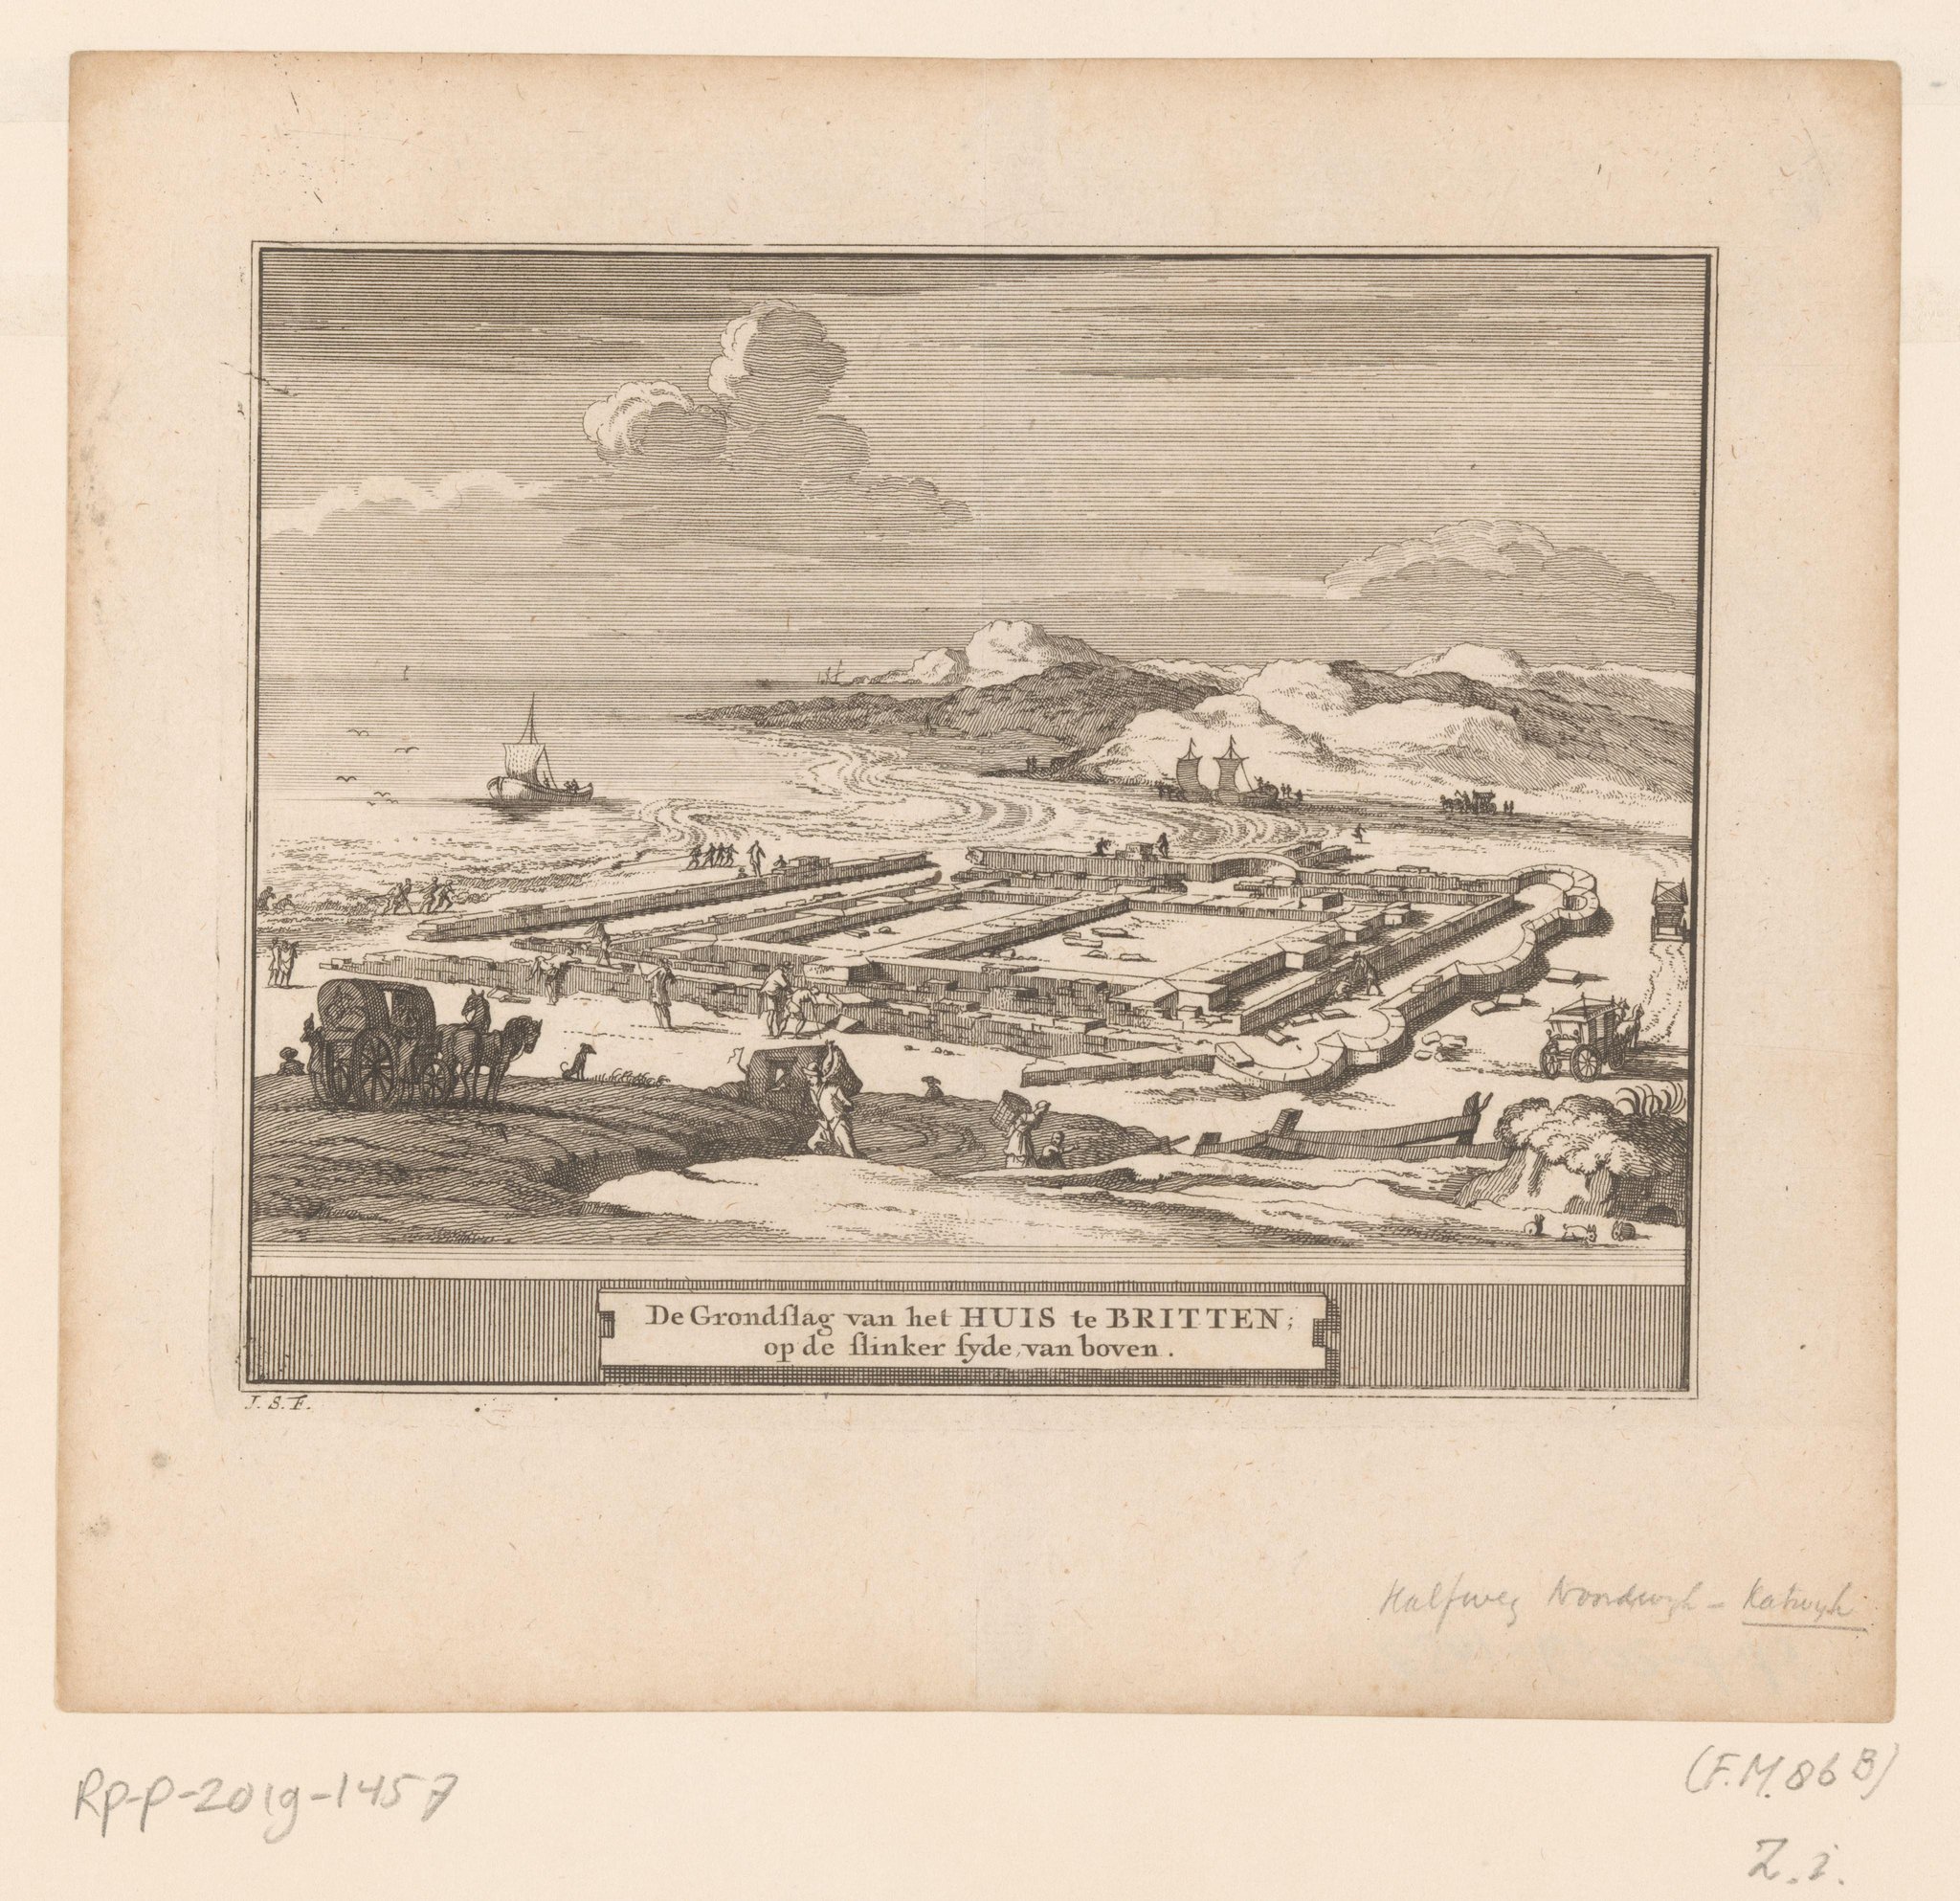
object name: print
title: De Grondslag van het Huis te Britten; op de slinker syde van boven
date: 1711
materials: paper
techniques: etching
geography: amsterdam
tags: landscape with ruins (+ city(-scape) with figures, staffage)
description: Prent voor het eerst gebruikt in: Smids, Ludolph. Schatkamer der Nederlandsse oudheden; of Woordenboek, behelsende Nederlands steden. Amsterdam: Pieter de Coup, 1711, tussen p. 44 en 45. Verscheen daarna mogelijk in heruitgaven van dit werk in 1737 en 1774. In 1721 verscheen er een uitgave met alleen de prenten: Nederlandsche oudheden, bestaande in zestig verbeeldingen (...) gelegen in Holland, 't Sticht van Utrecht en Gelderland enz. Amsterdam: Hendrik Bosch, 1721.